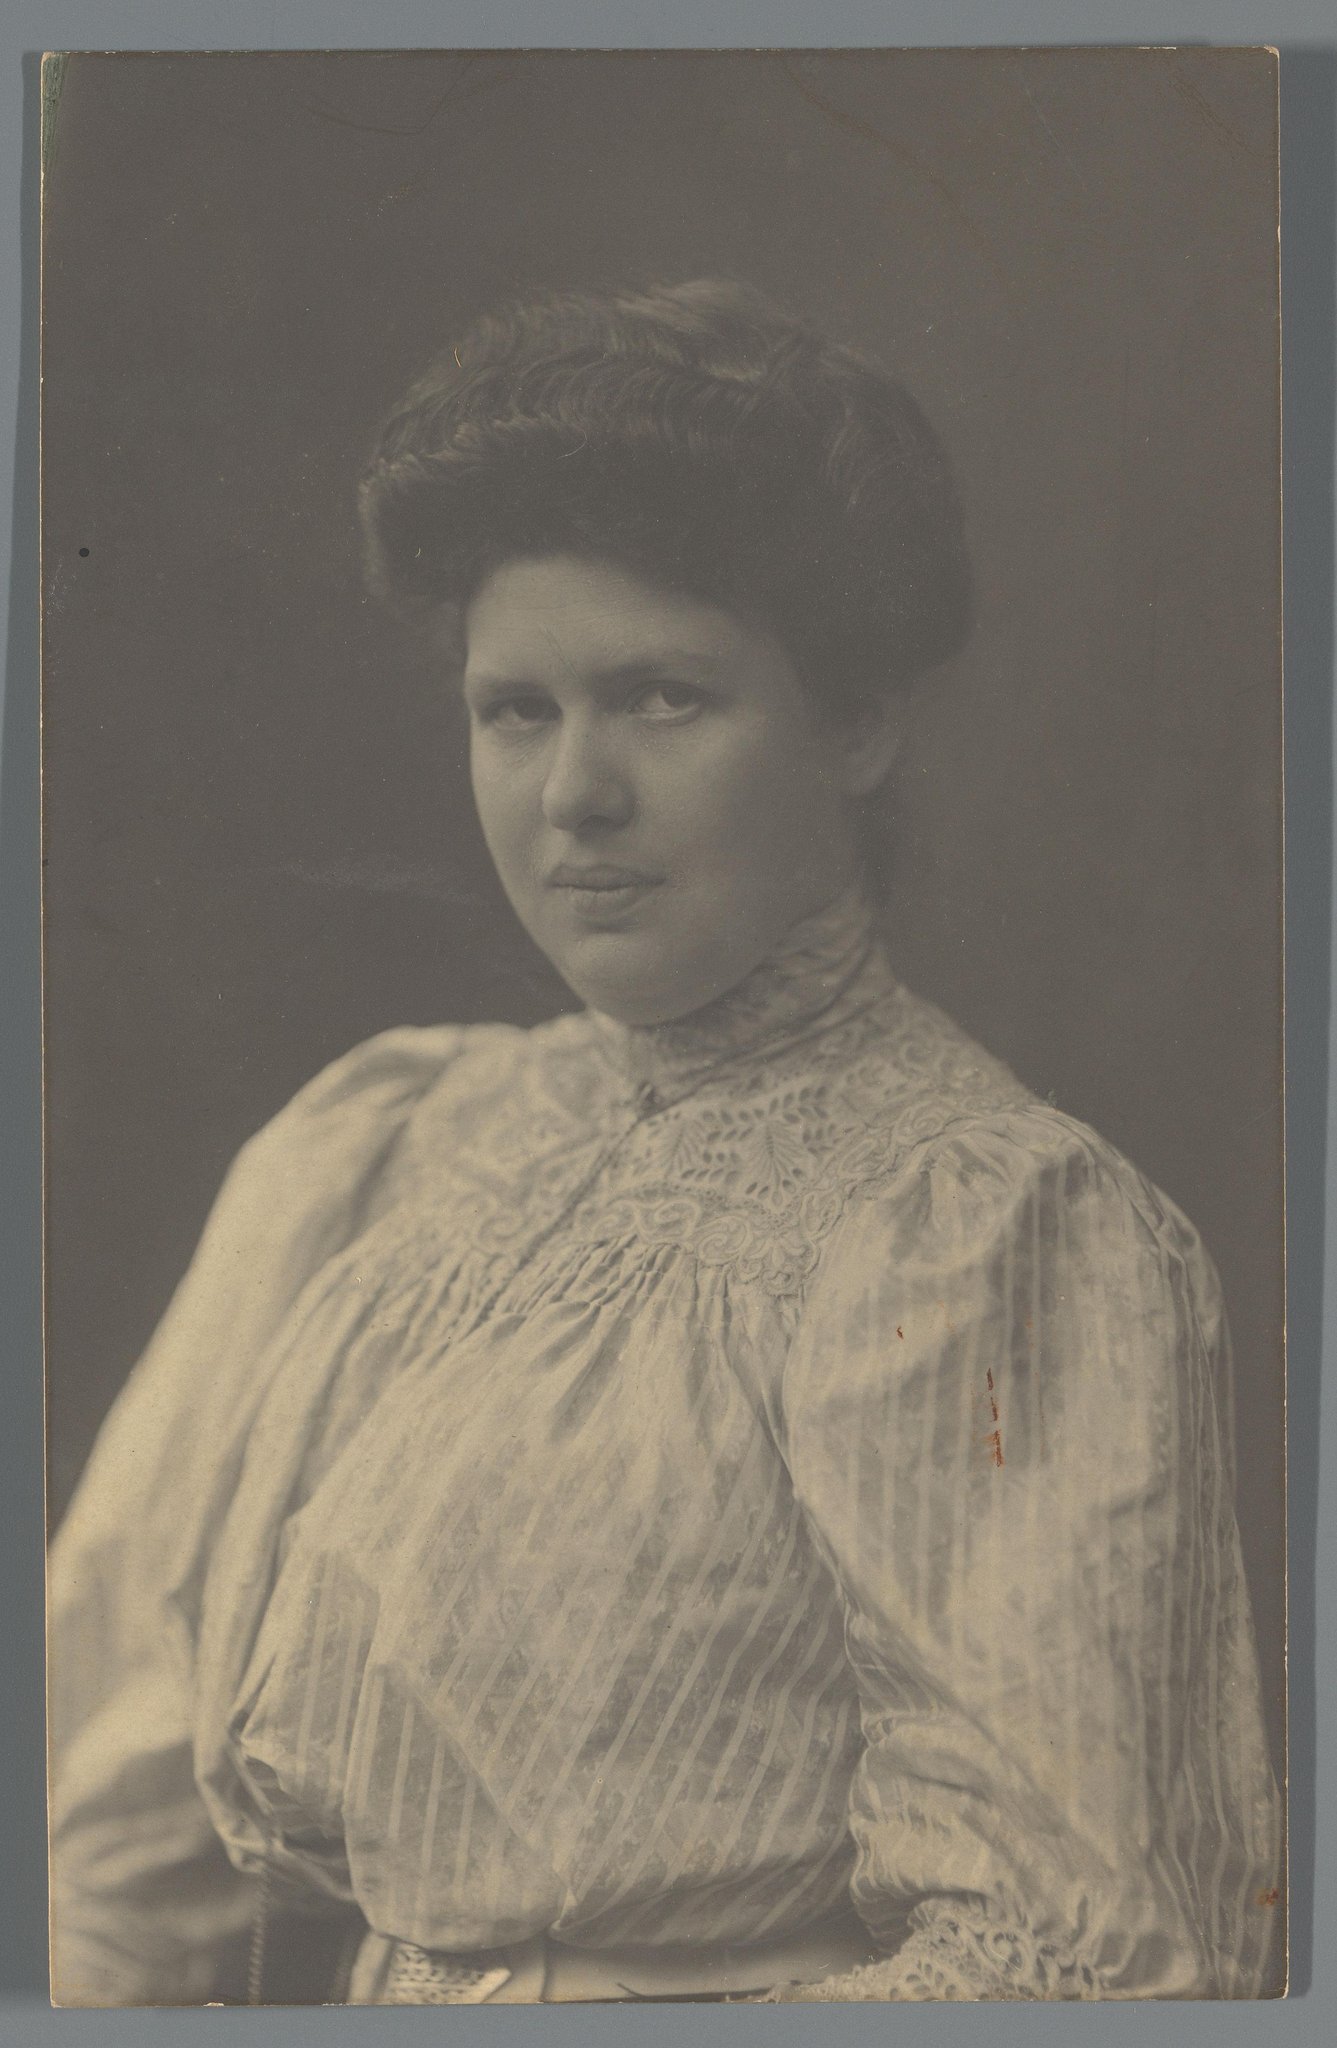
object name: ansichtkaart, prentbriefkaart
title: Portret van tante Leo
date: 1900-1904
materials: cardboard, photographic support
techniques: photography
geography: the hague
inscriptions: inscription: ‘tante Leo’, name: ‘Delboy - Baer, Prinsestraat 90’